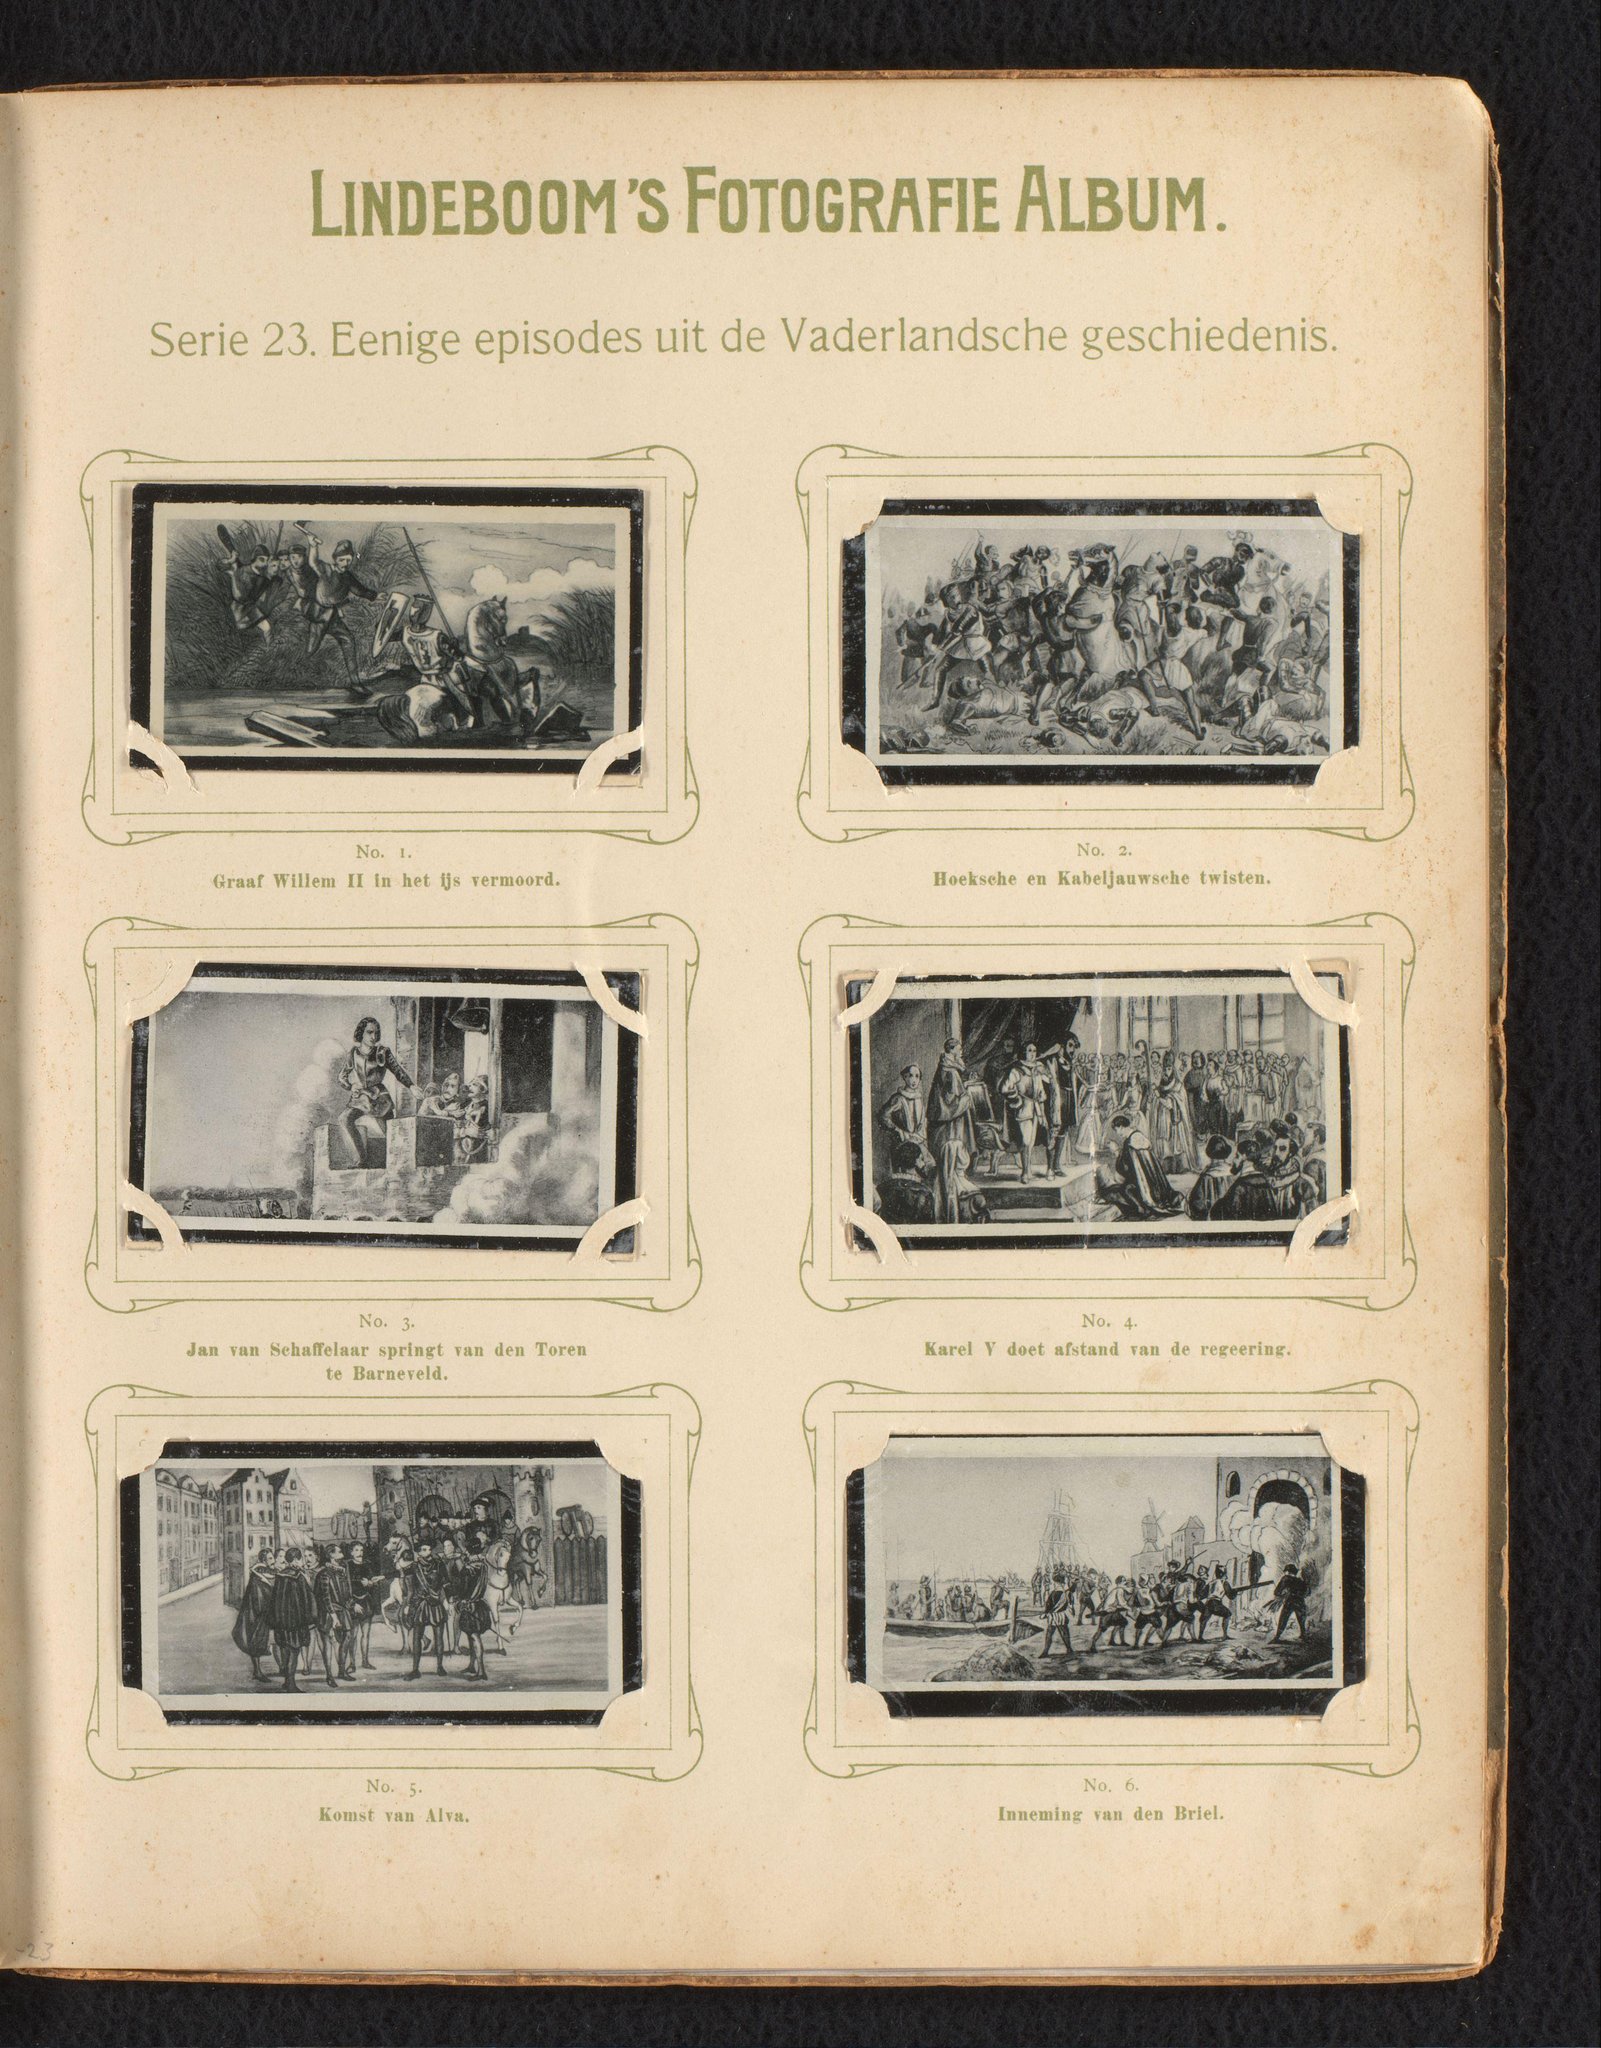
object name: album leaf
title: Eenige episodes uit de vaderlandsche geschiedenis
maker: Anonymous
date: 1905-1906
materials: cardboard, paper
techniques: photograph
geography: amsterdam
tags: warfare; military affairs, brielle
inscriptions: inscription: ‘Serie 23.’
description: Dergelijke prenten stonden bekend als 'zwartjes'. Men verkreeg ze bij aanschaf van bepaalde merken thee, cacao, sigaretten, beschuit, etc. om te verzamelen. Er waren speciaal voor de 'zwartjes' vervaardigde verzamelalbums in omloop.